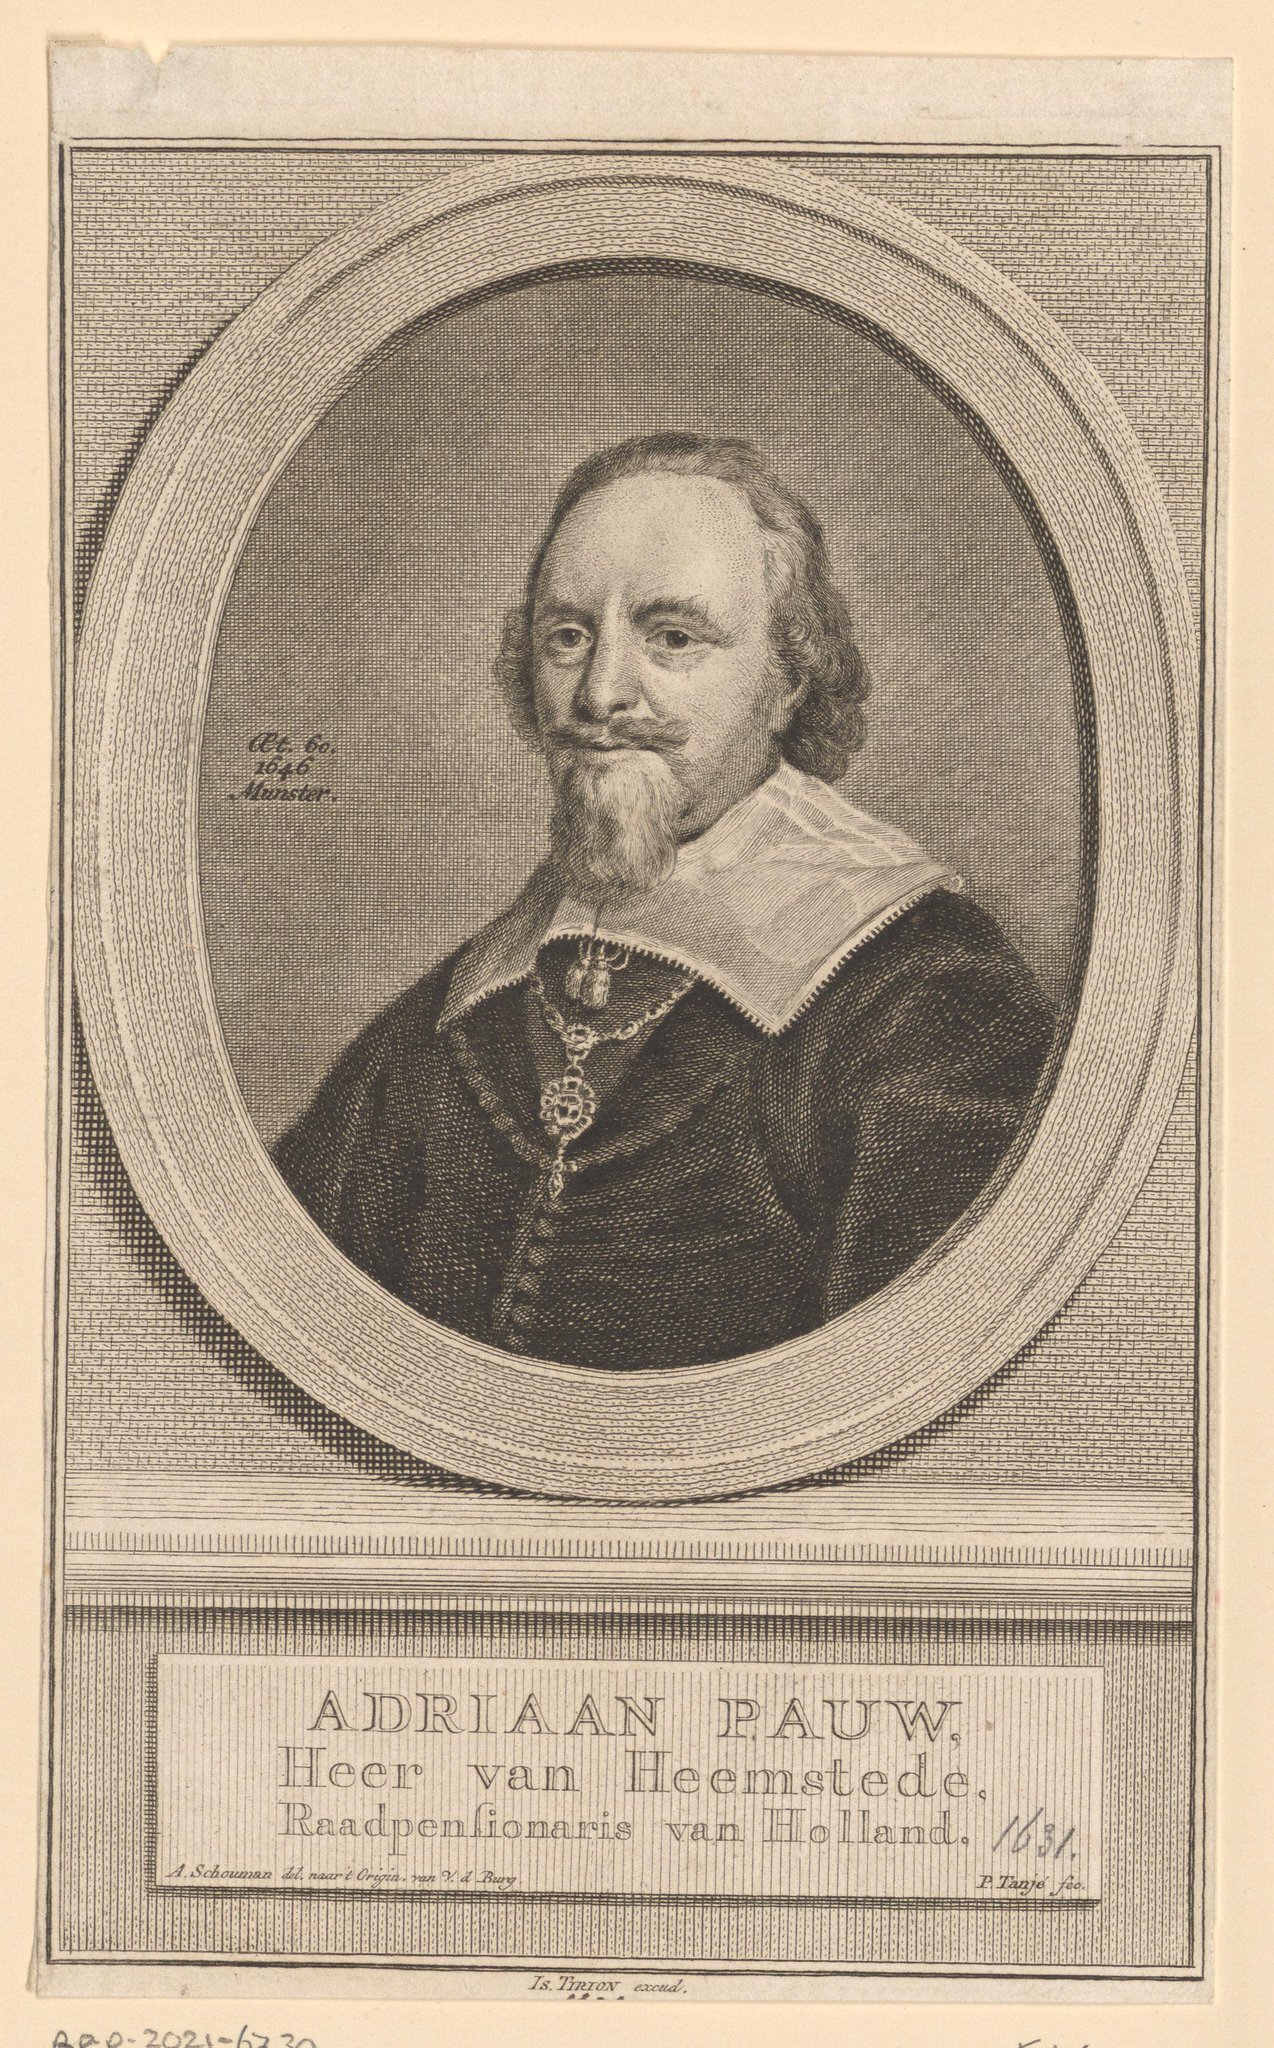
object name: print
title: Portret van Adriaen Pauw op 60-jarige leeftijd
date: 1716-1761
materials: paper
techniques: engraving, etching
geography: amsterdam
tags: the hague, politician, adriaen pauw (1585-1653), adult man, historical persons